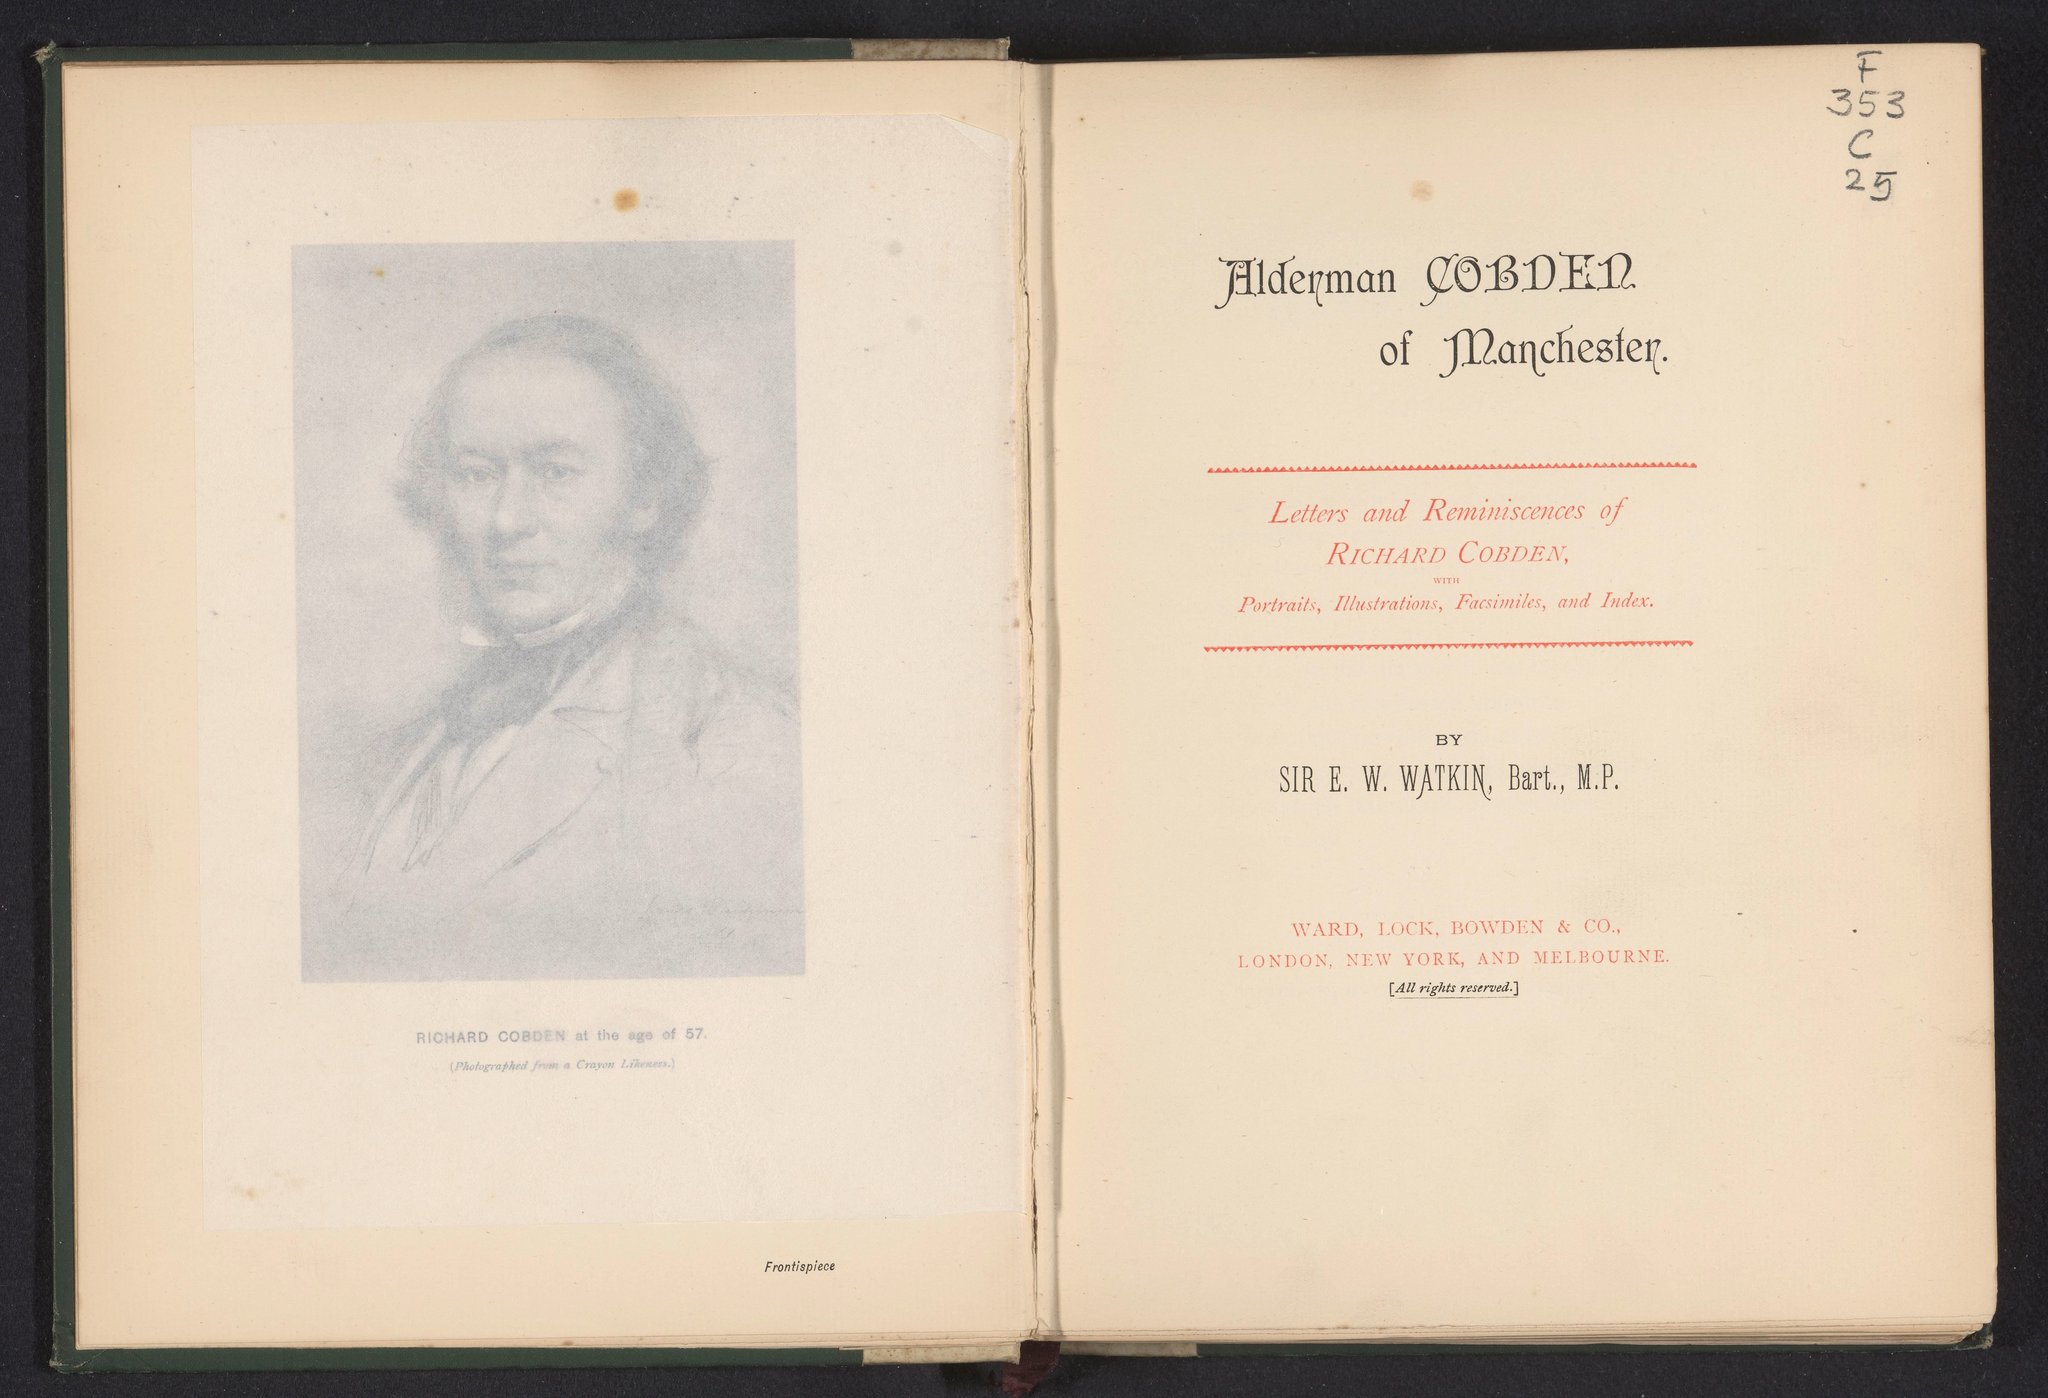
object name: book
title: Alderman Cobden of Manchester letters and reminiscences of alderman Cobden, portraits, illustrations, facsimiles, and index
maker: edward watkin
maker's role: politician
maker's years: 1819-1901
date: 1891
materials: linen, paper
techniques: woodburytype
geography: london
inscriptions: number: ‘Edition de Luxe. Four hundred copies printed for sale, of which this is No. 396, Signed [...]’, name: ‘ex libris SFJ’, name: ‘C. & E. Brown, Booksellers, 119, Queen's Road, Bayswater, W. (Late of 13. Bishop's Road, W.)’